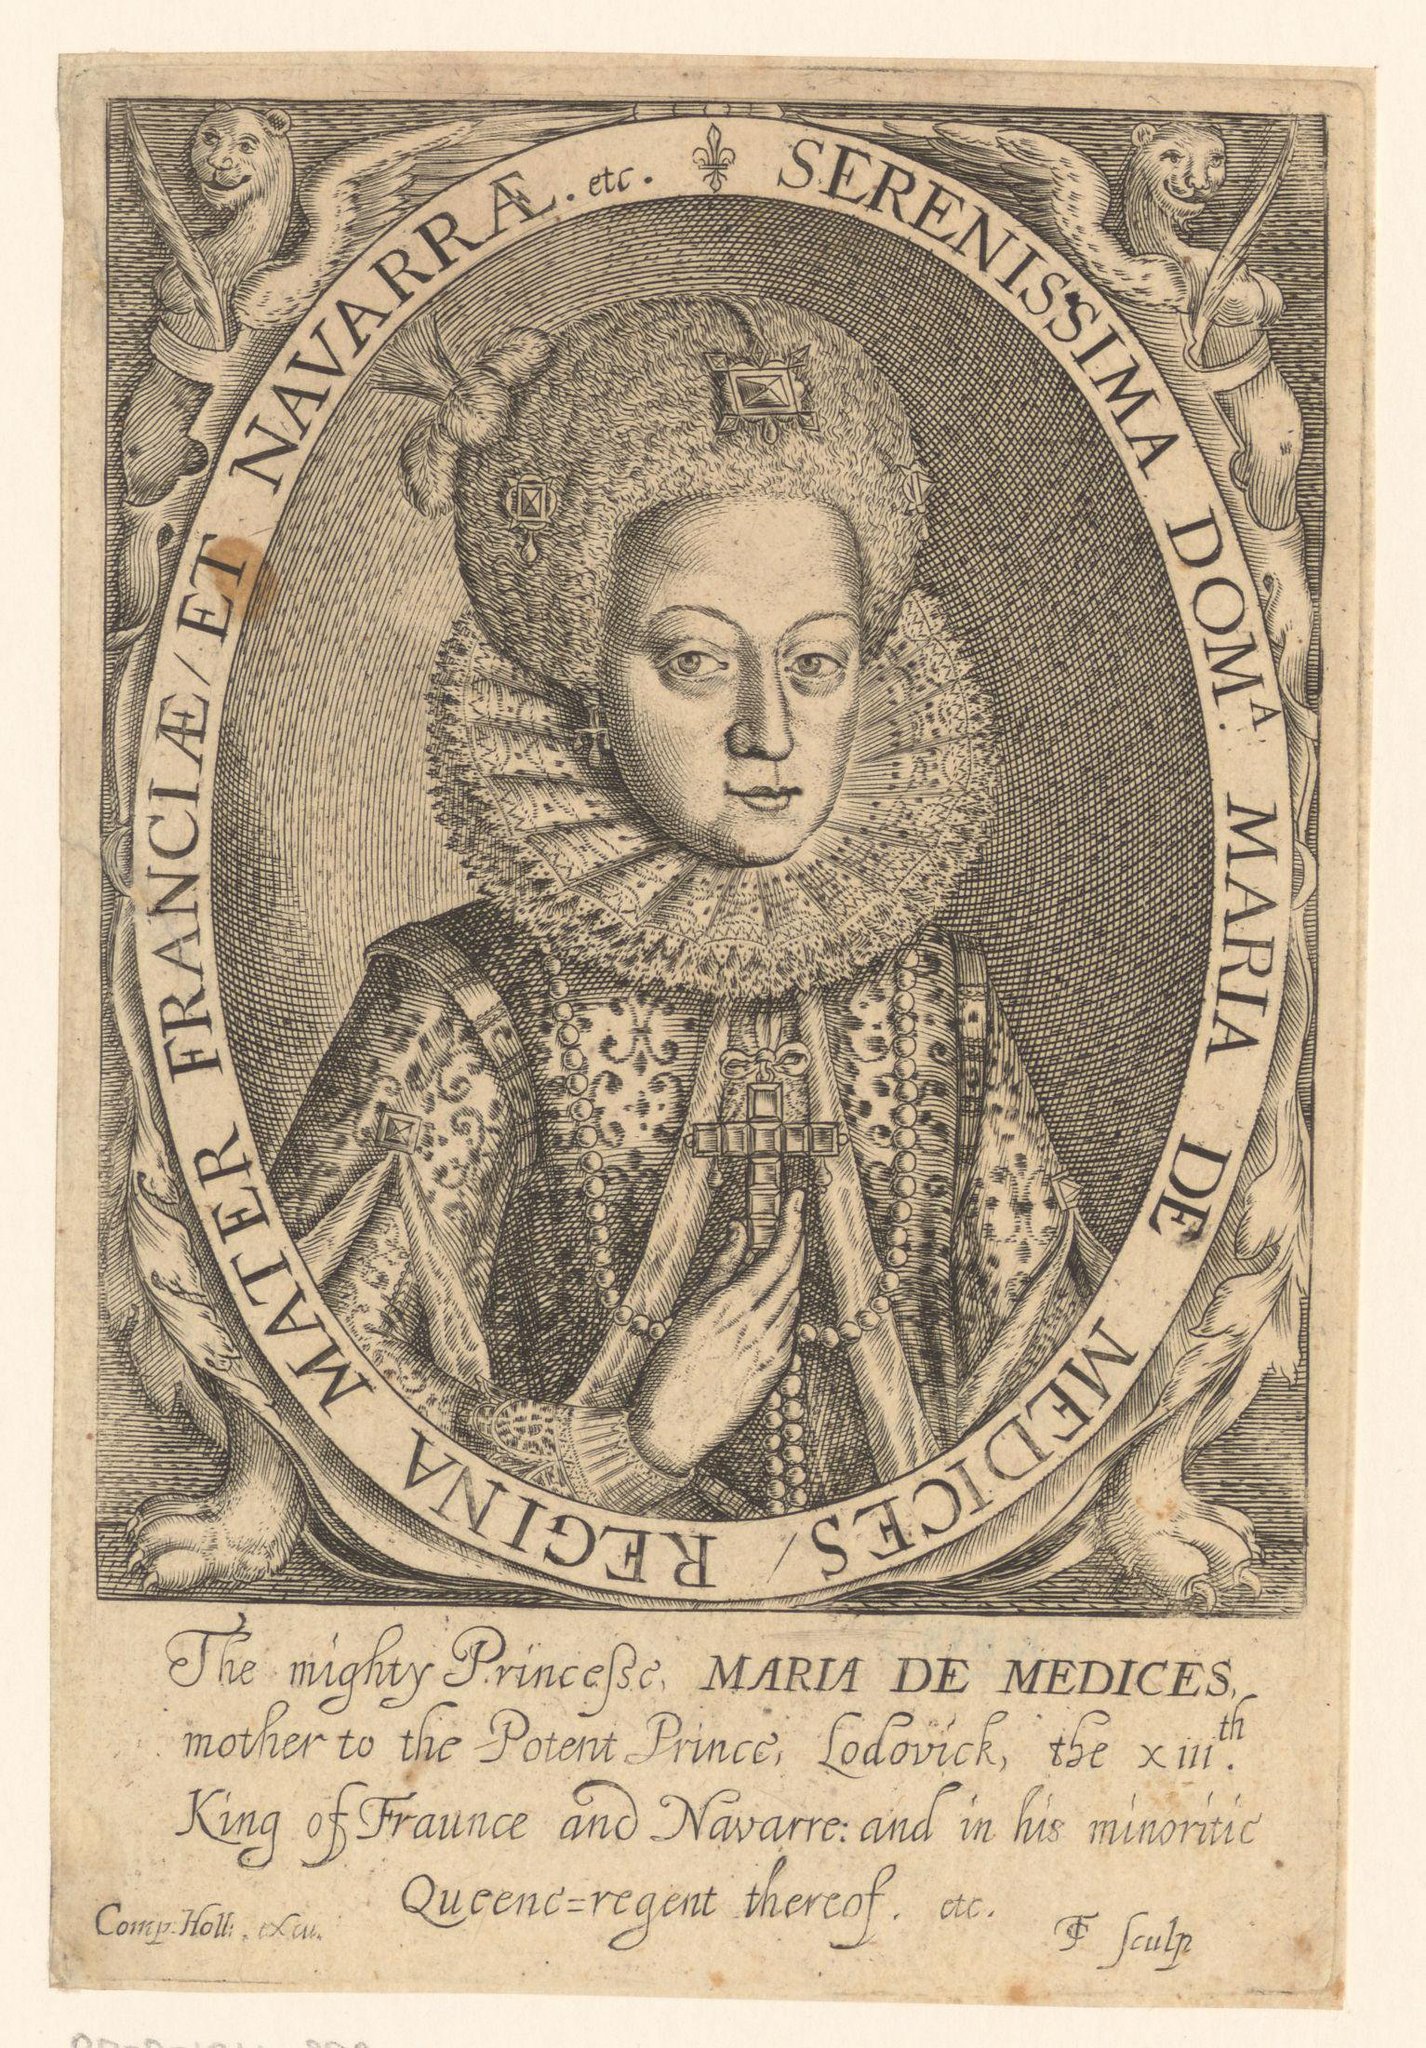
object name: print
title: Portret van Maria de' Medici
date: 1579-1621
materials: paper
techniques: engraving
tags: print maker, maria de' medici, historical persons, ruler, sovereign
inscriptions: collector's mark: Lugt 2228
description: Tekst in het Latijn in de omlijsting en tekst in het Engels in de ondermarge.